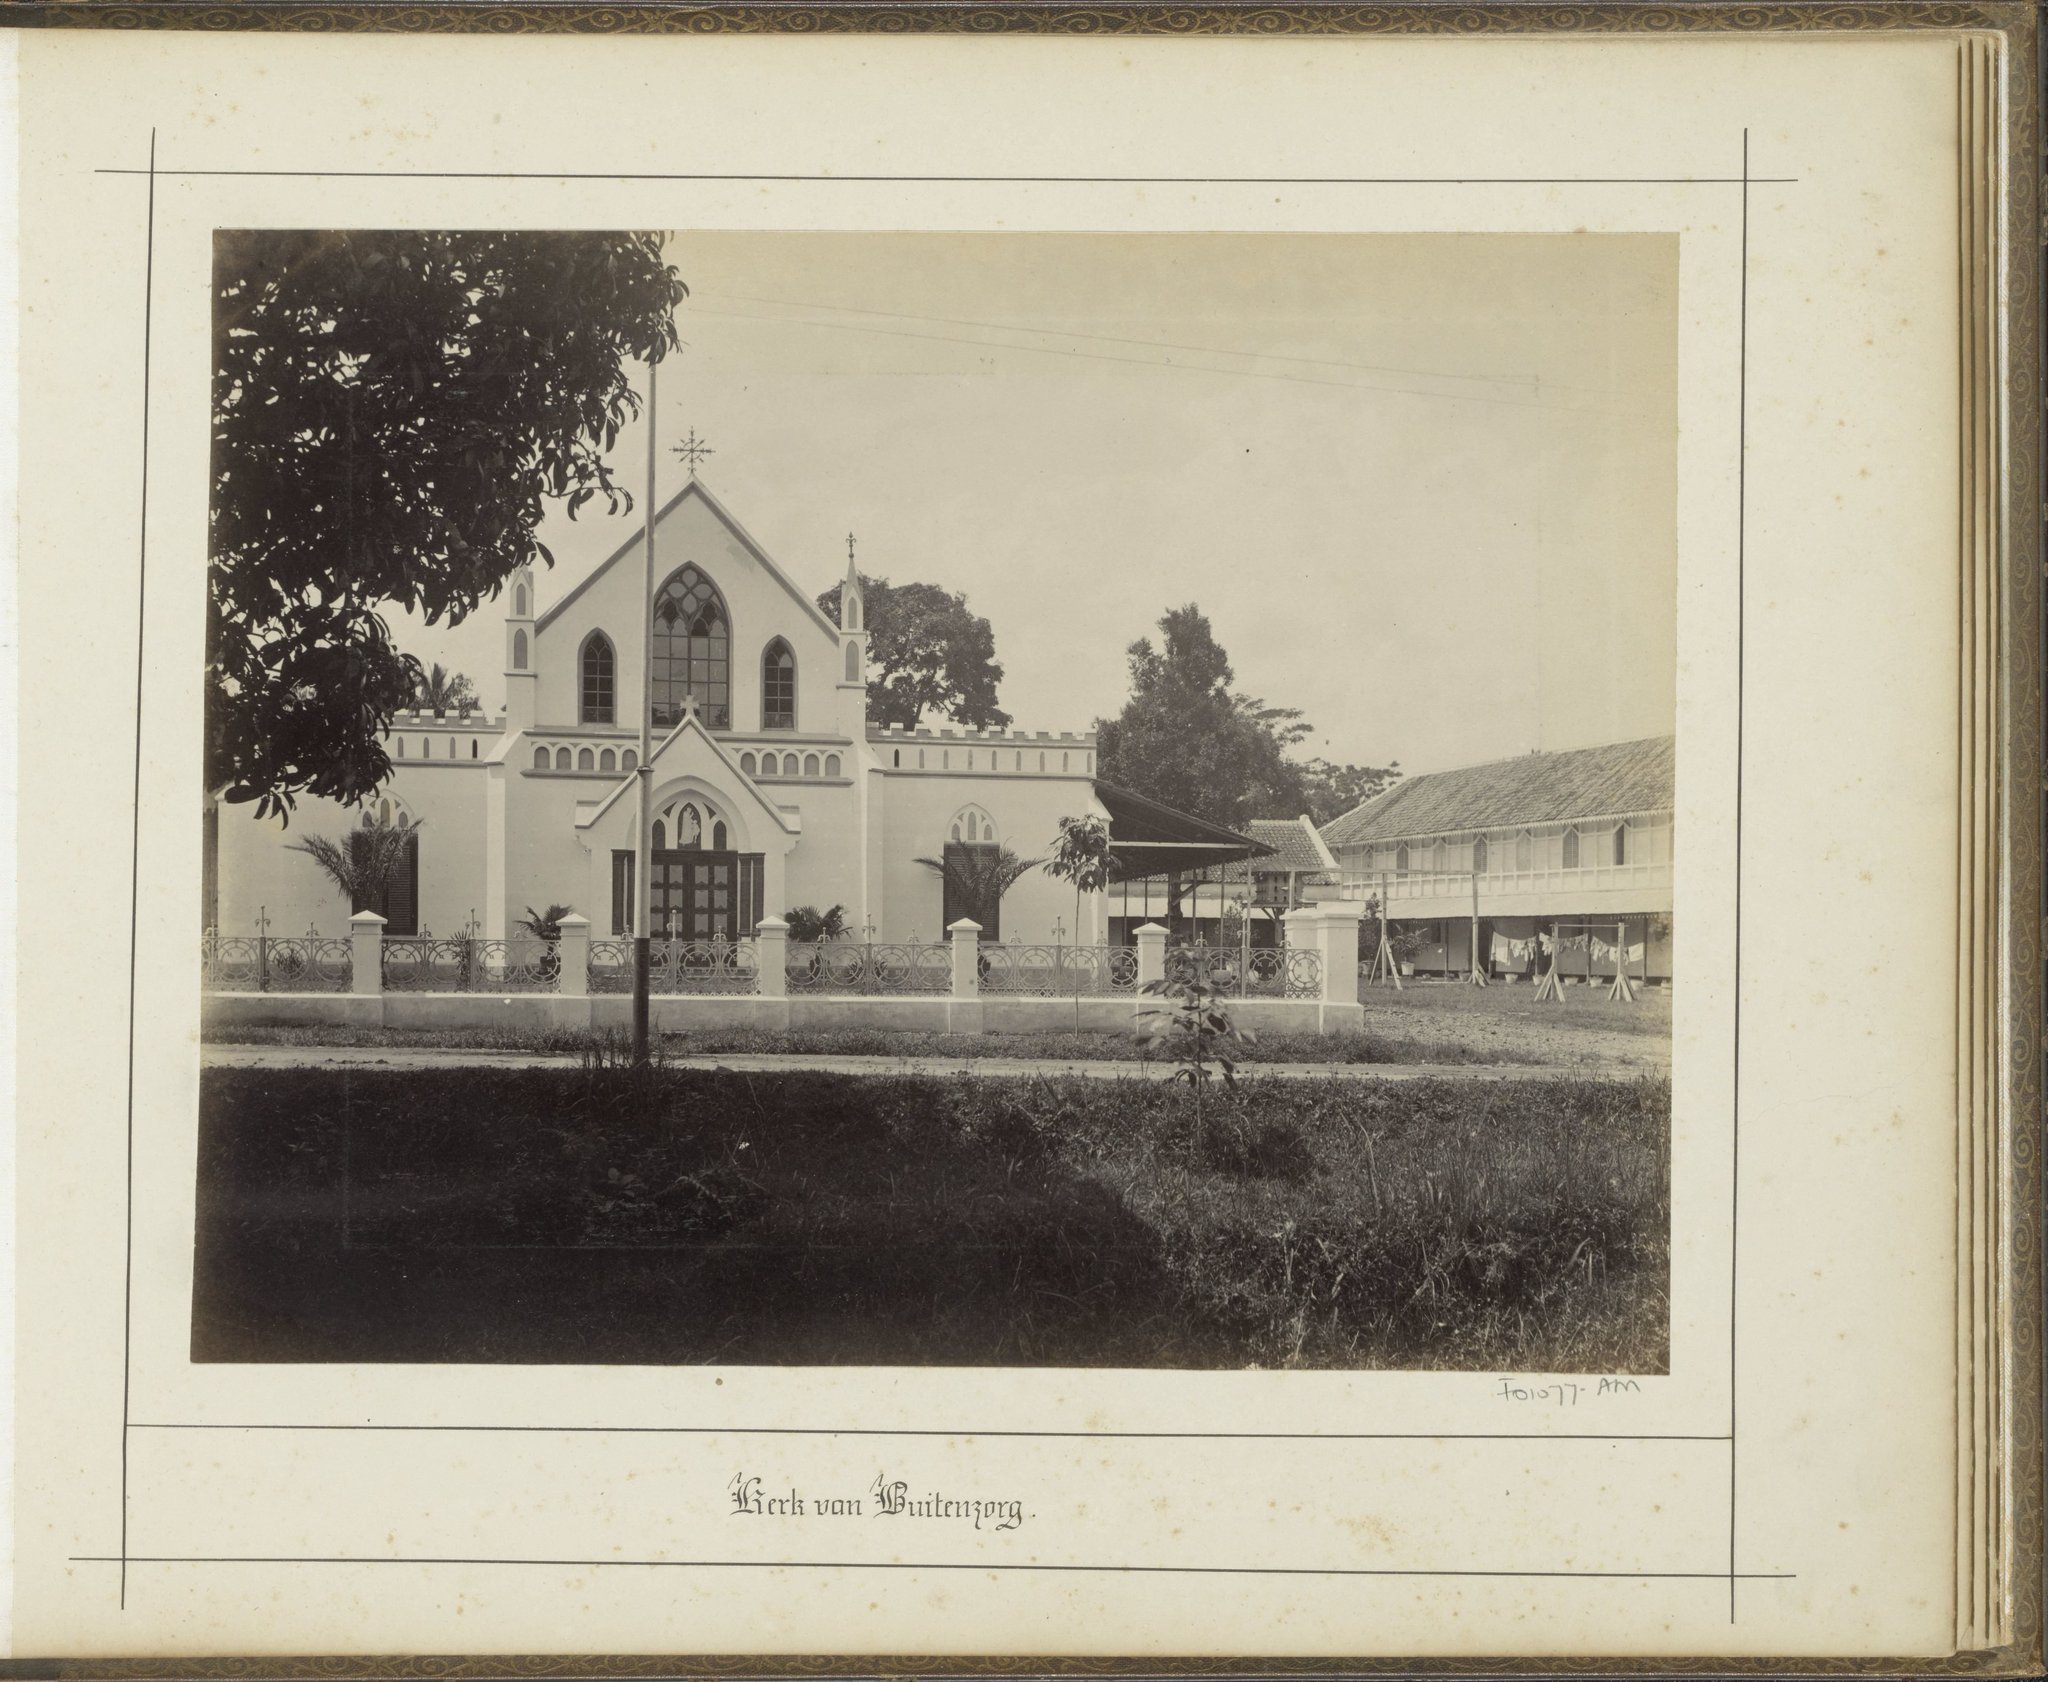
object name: photograph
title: Exterieur van de kerk van Buitenzorg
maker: Anonymous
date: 1890-1910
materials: cardboard, photographic support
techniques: albumen print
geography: buitenzorg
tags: church (exterior)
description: Onderdeel van Album met foto's van Batavia en van de zusters Ursulinen.